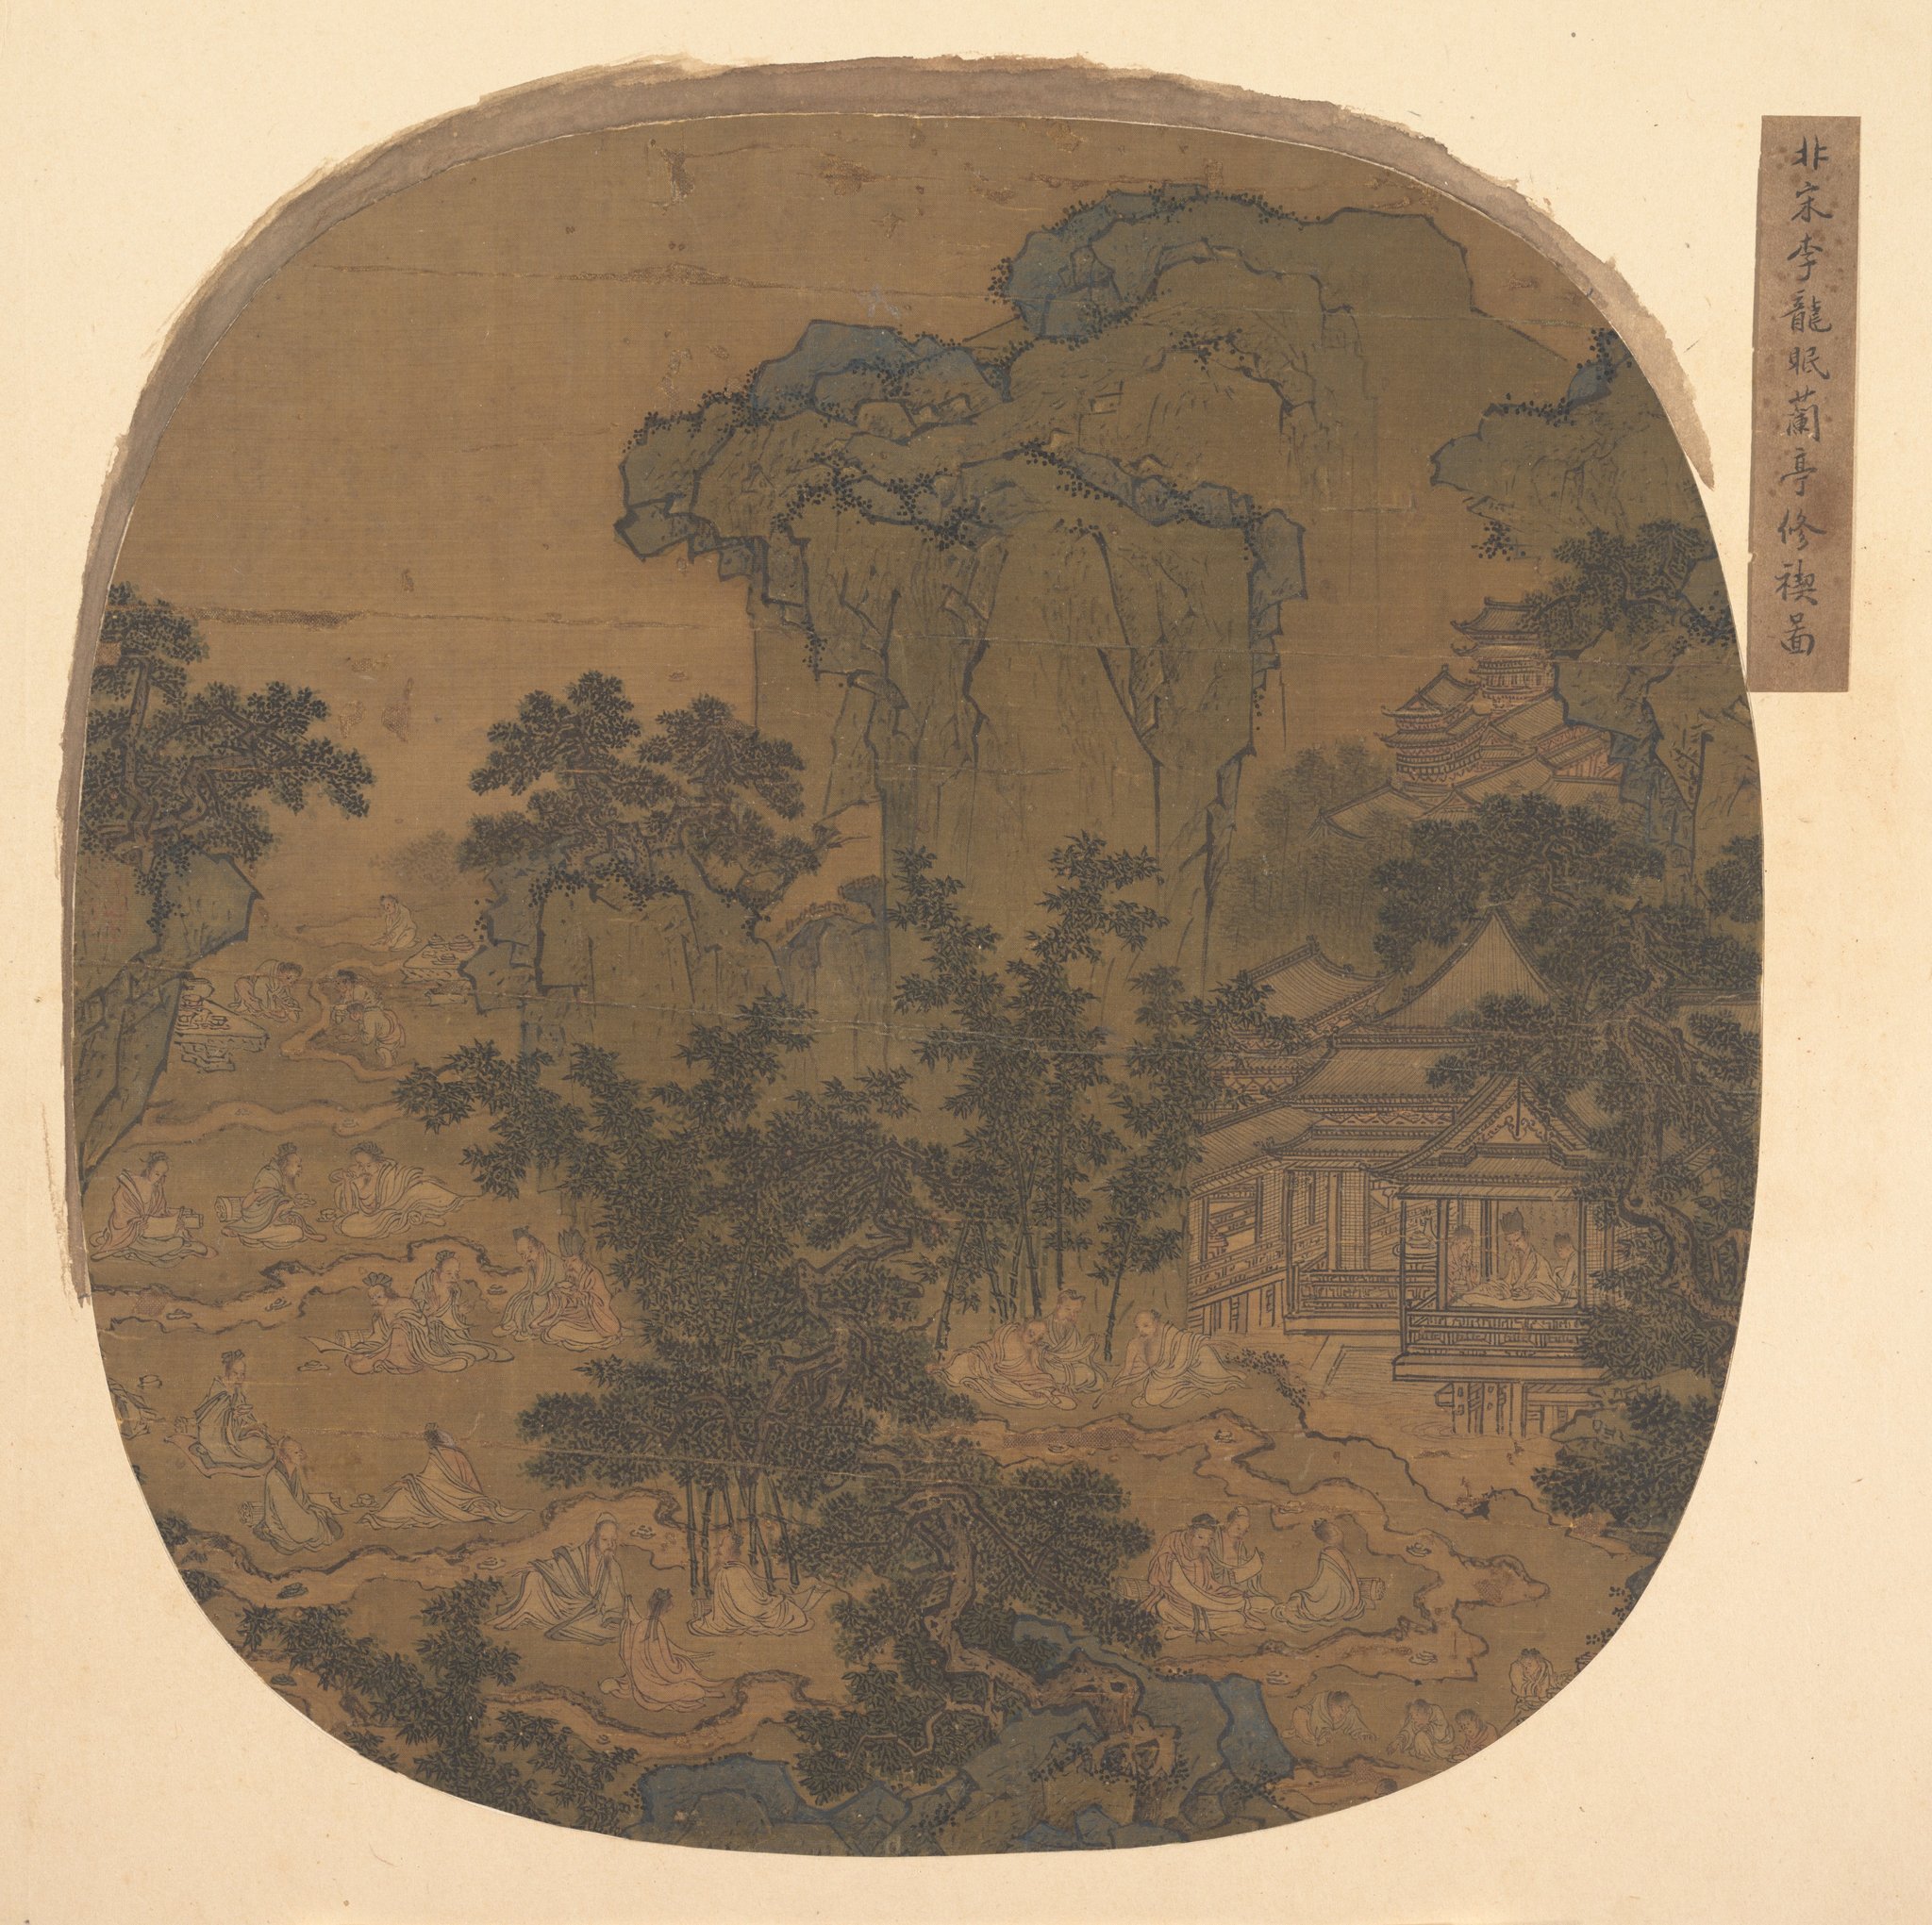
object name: fan mounted a an album leaf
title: Gathering at the Orchid Pavilion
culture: chinese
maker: unidentified artist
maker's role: artist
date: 1501-1600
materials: ink, silk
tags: men,landscapes,pavilions